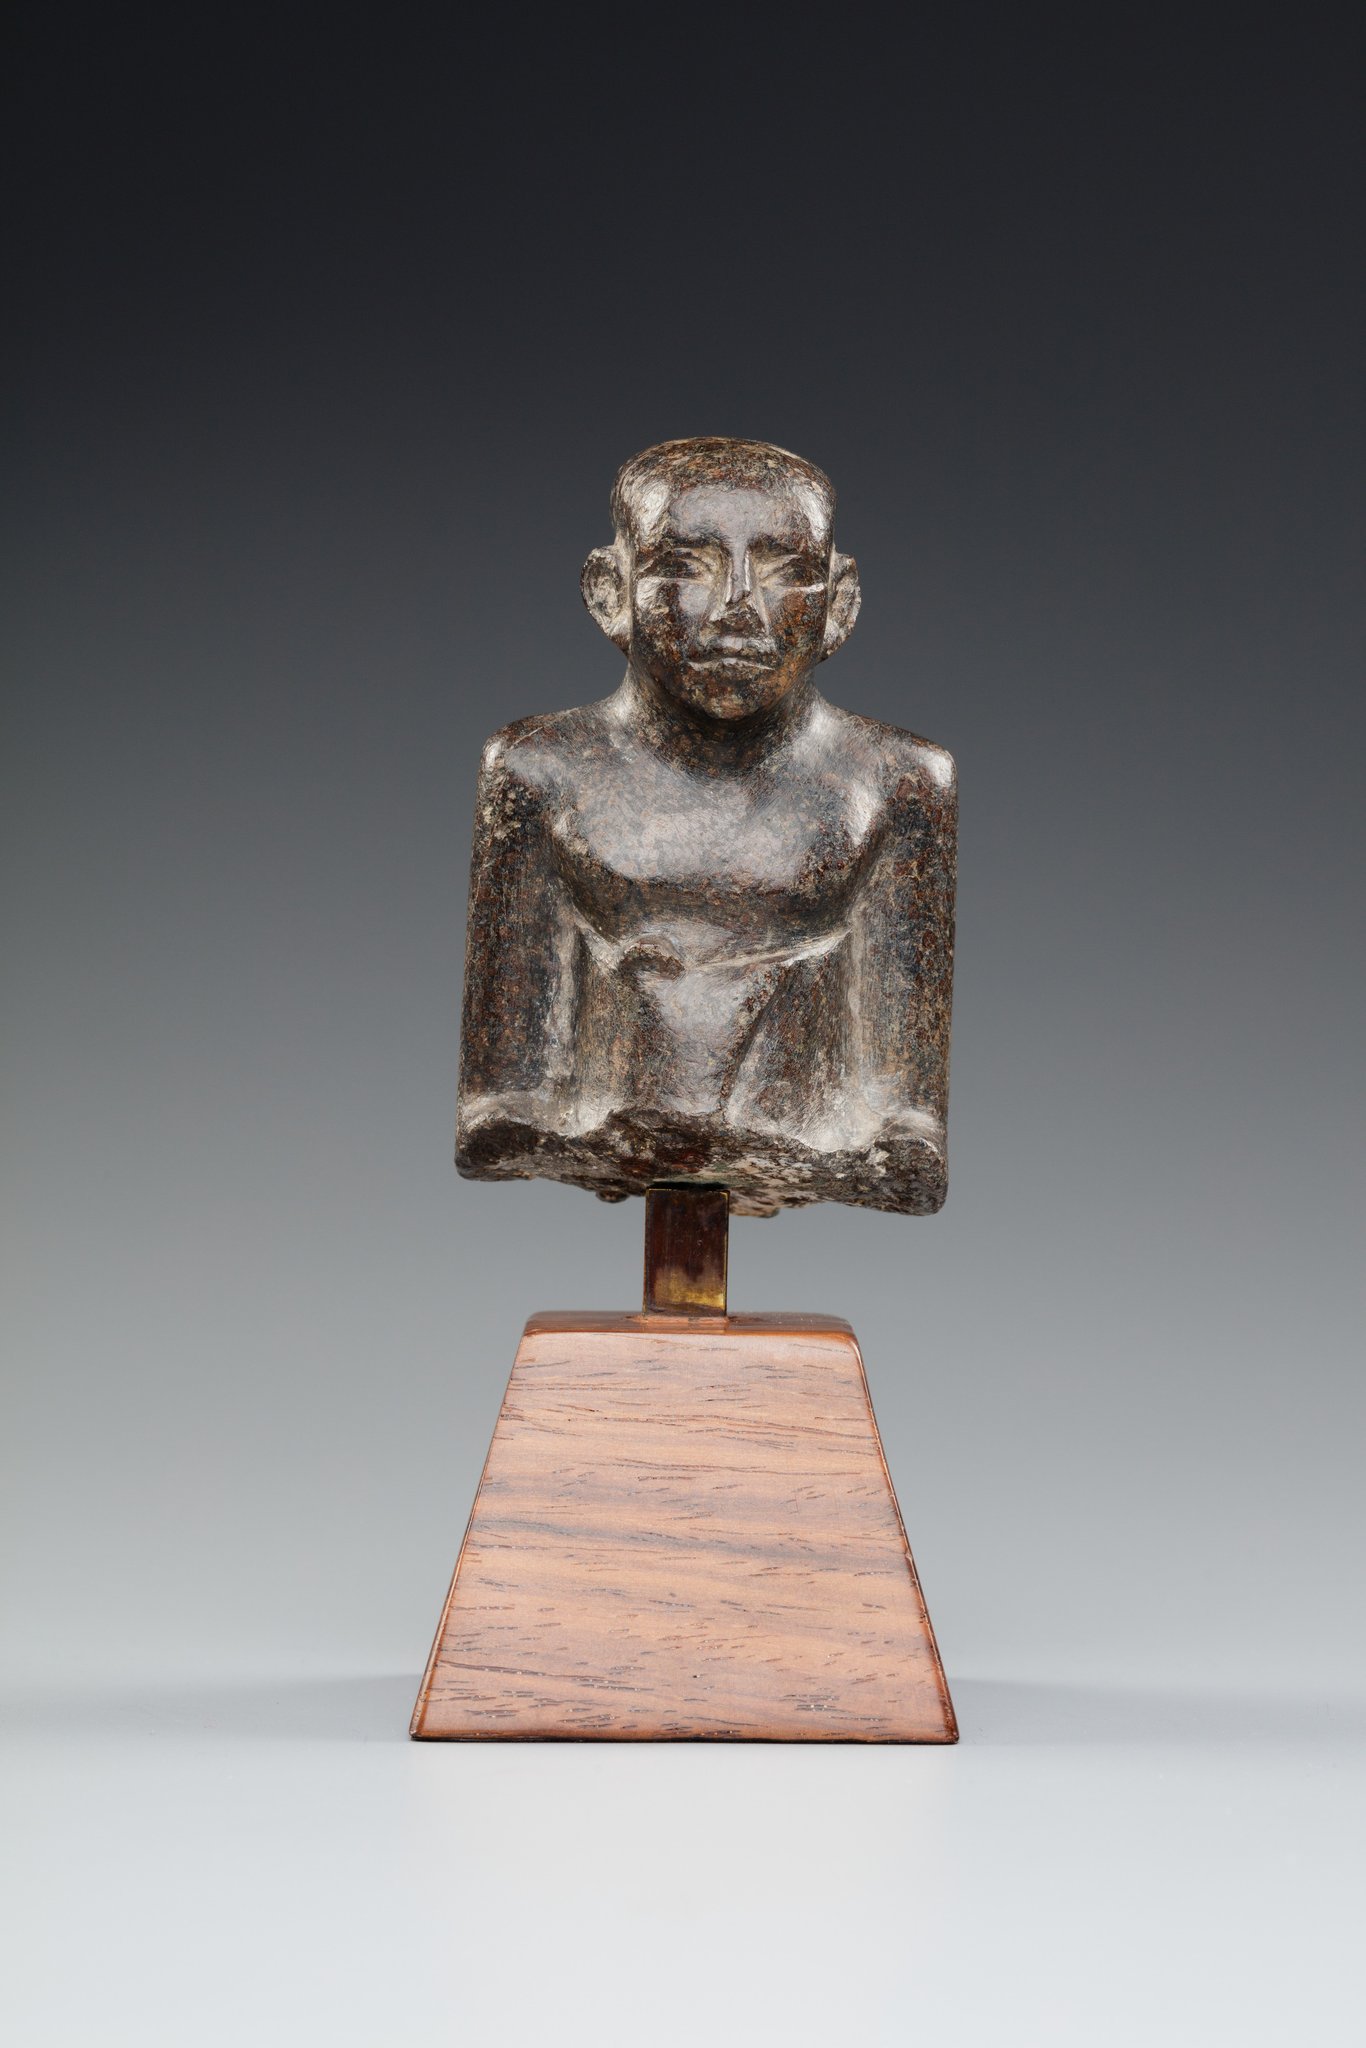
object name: upper part of a seated figure in a long kilt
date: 1800-1650 BCE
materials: stone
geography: egypt